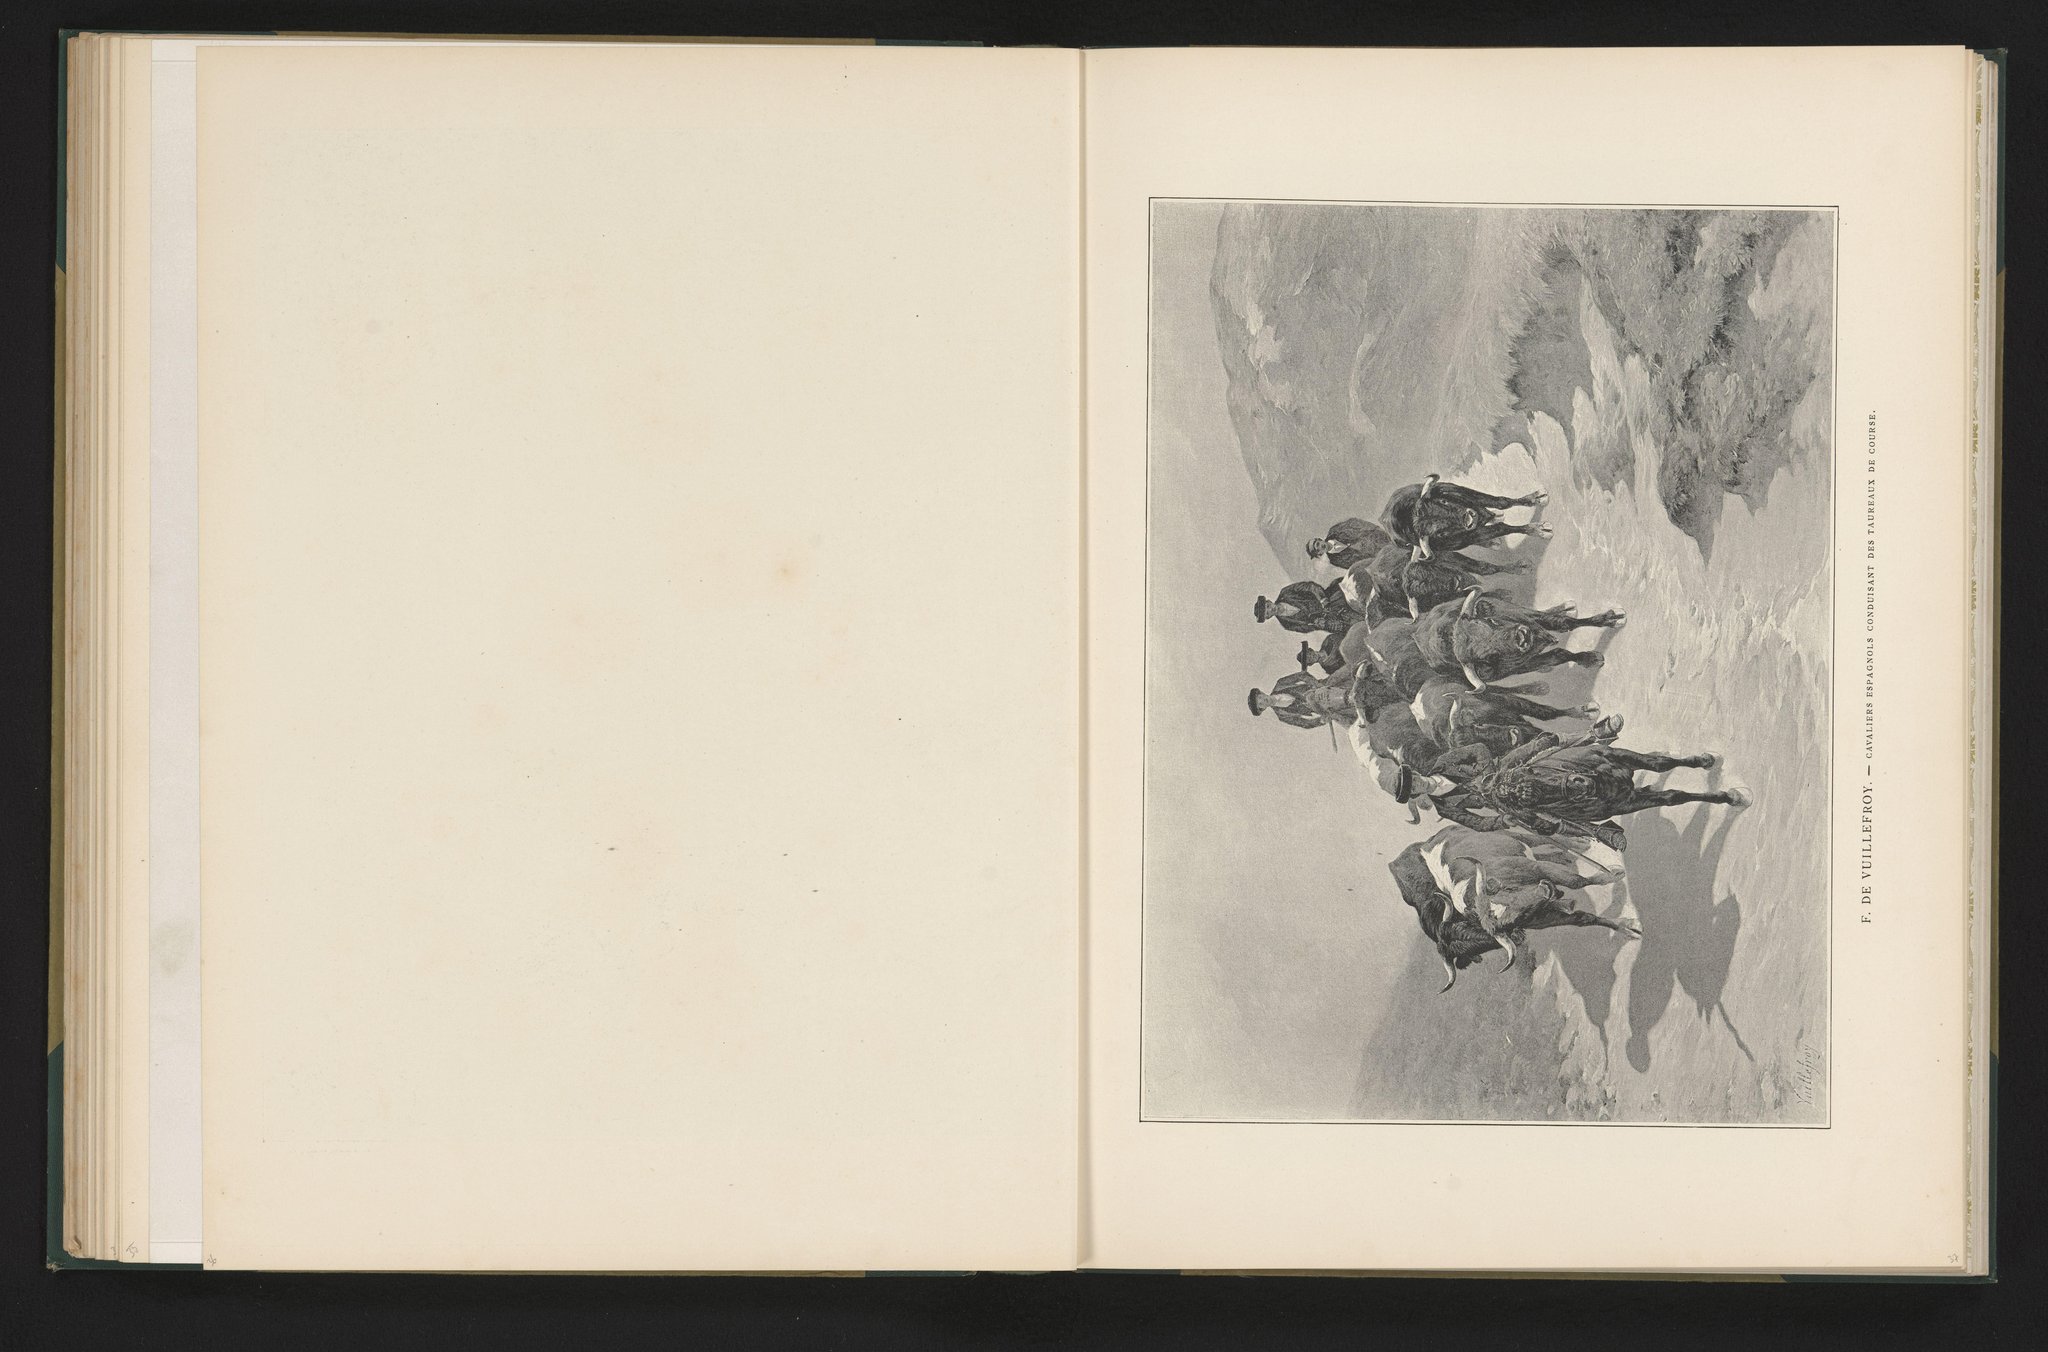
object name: page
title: Reproductie van een schilderij met Spaanse ruiters met stieren door Félix de Dominique Vuillefroy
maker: Anonymous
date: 1885-1901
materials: paper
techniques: autotype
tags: herding, herdsman, herdswoman, shepherd, shepherdess, cowherd, etc., landscapes in the temperate zone (+ landscape with figures, staffage)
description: Prent op pagina 13 van Figaro-Salon (par Albert Wolff).